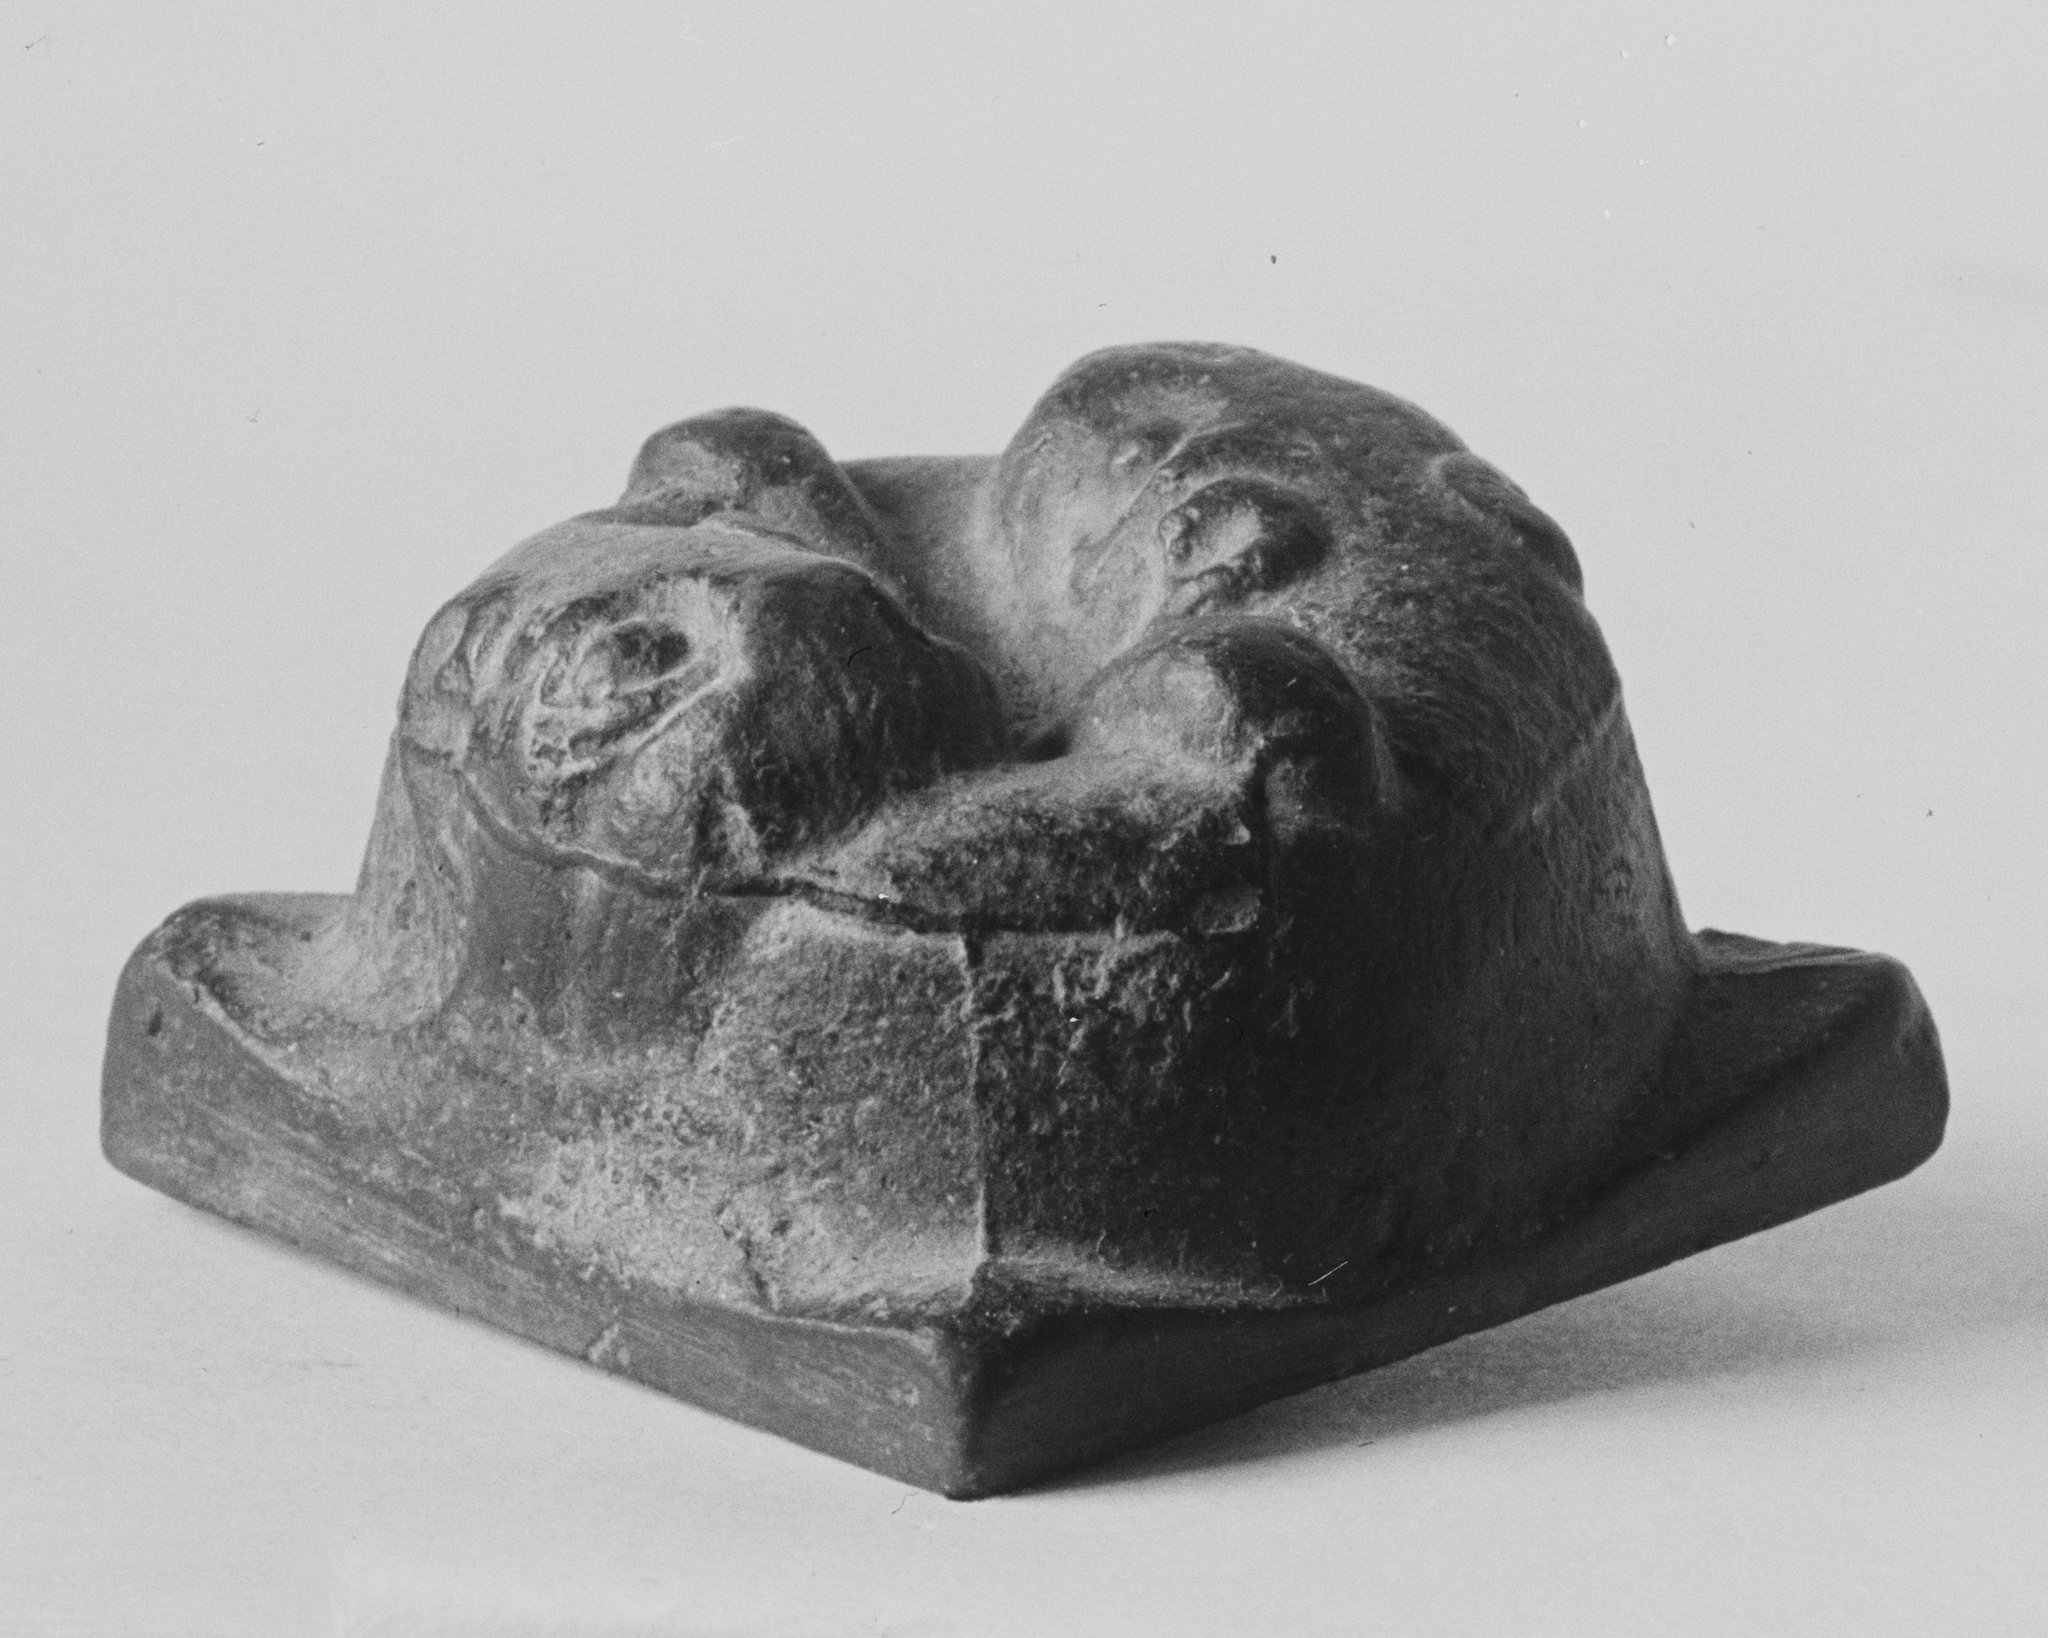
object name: weight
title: Sleeve weight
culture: chinese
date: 206 BCE-220 CE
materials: clay